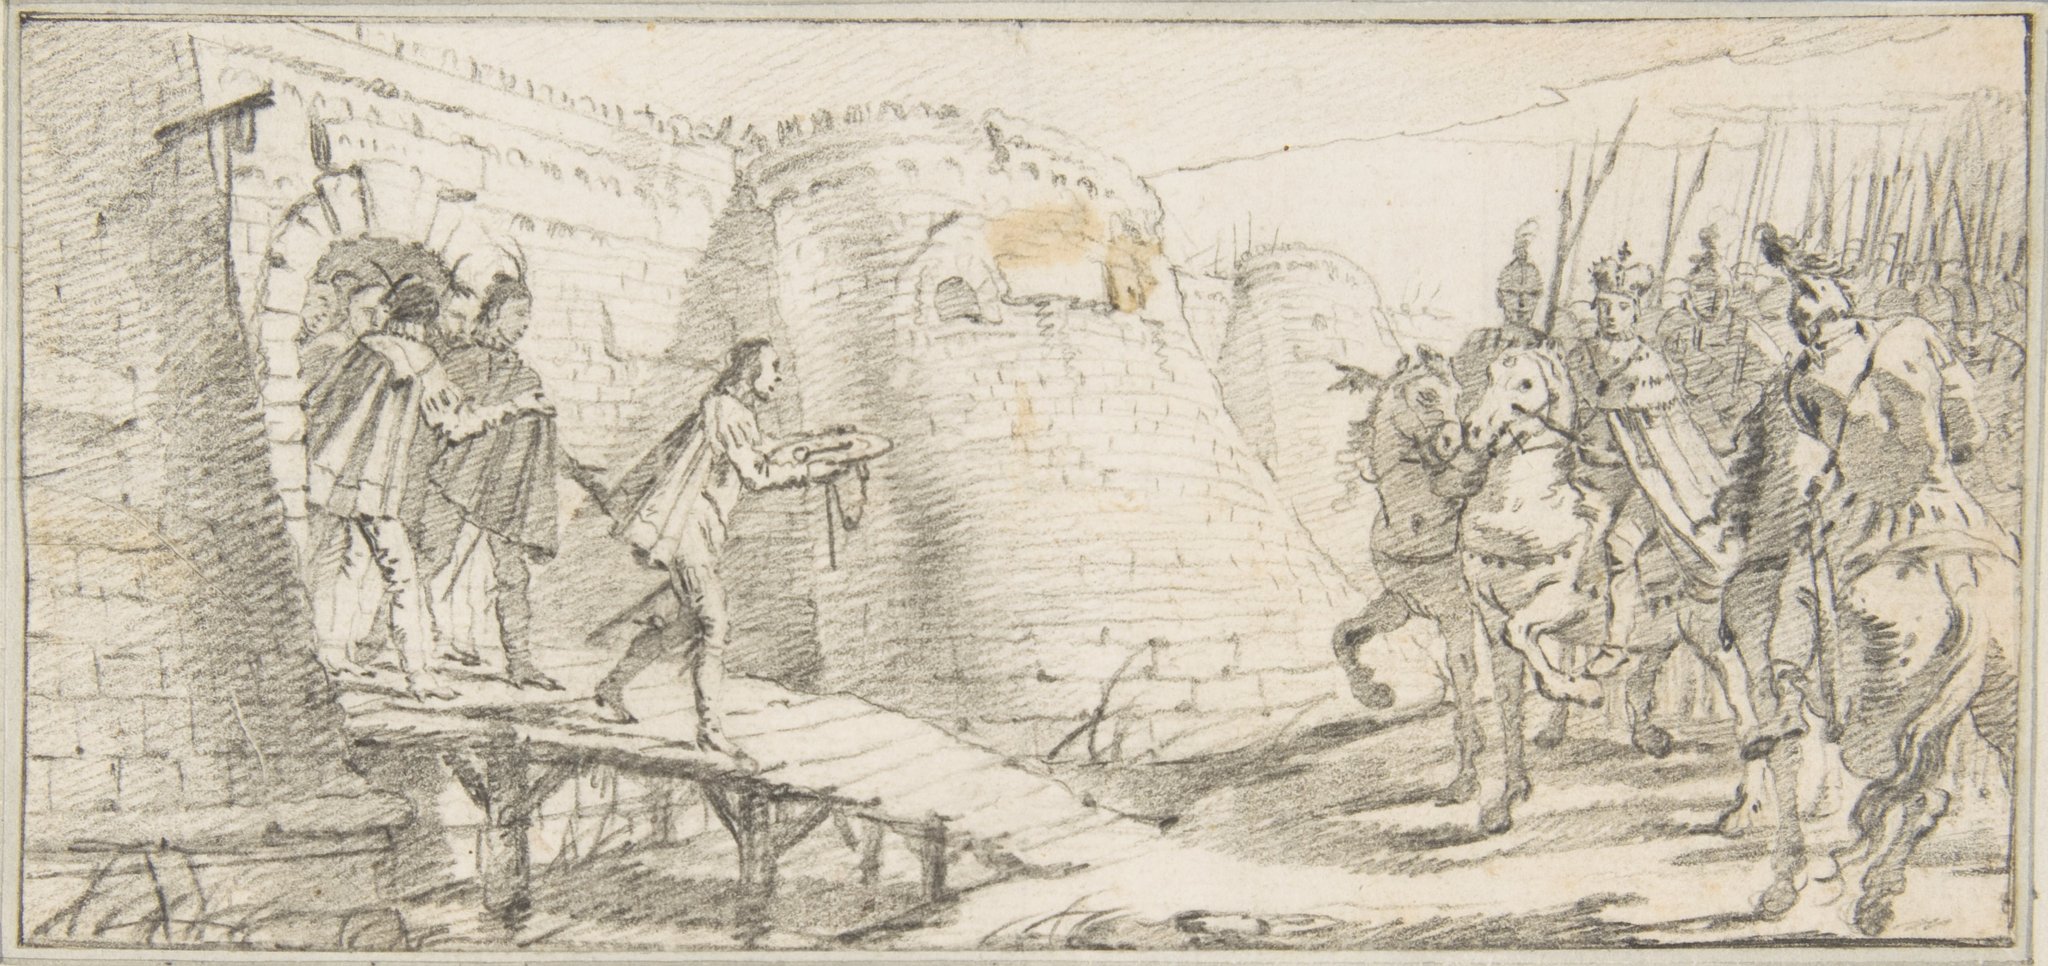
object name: drawing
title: Illustration for a Book: Surrender of the Keys of a City to an Emperor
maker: giovanni battista tiepolo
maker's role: artist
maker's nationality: italian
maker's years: 1696-1770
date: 1696-1770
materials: chalk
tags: men,horses,keys